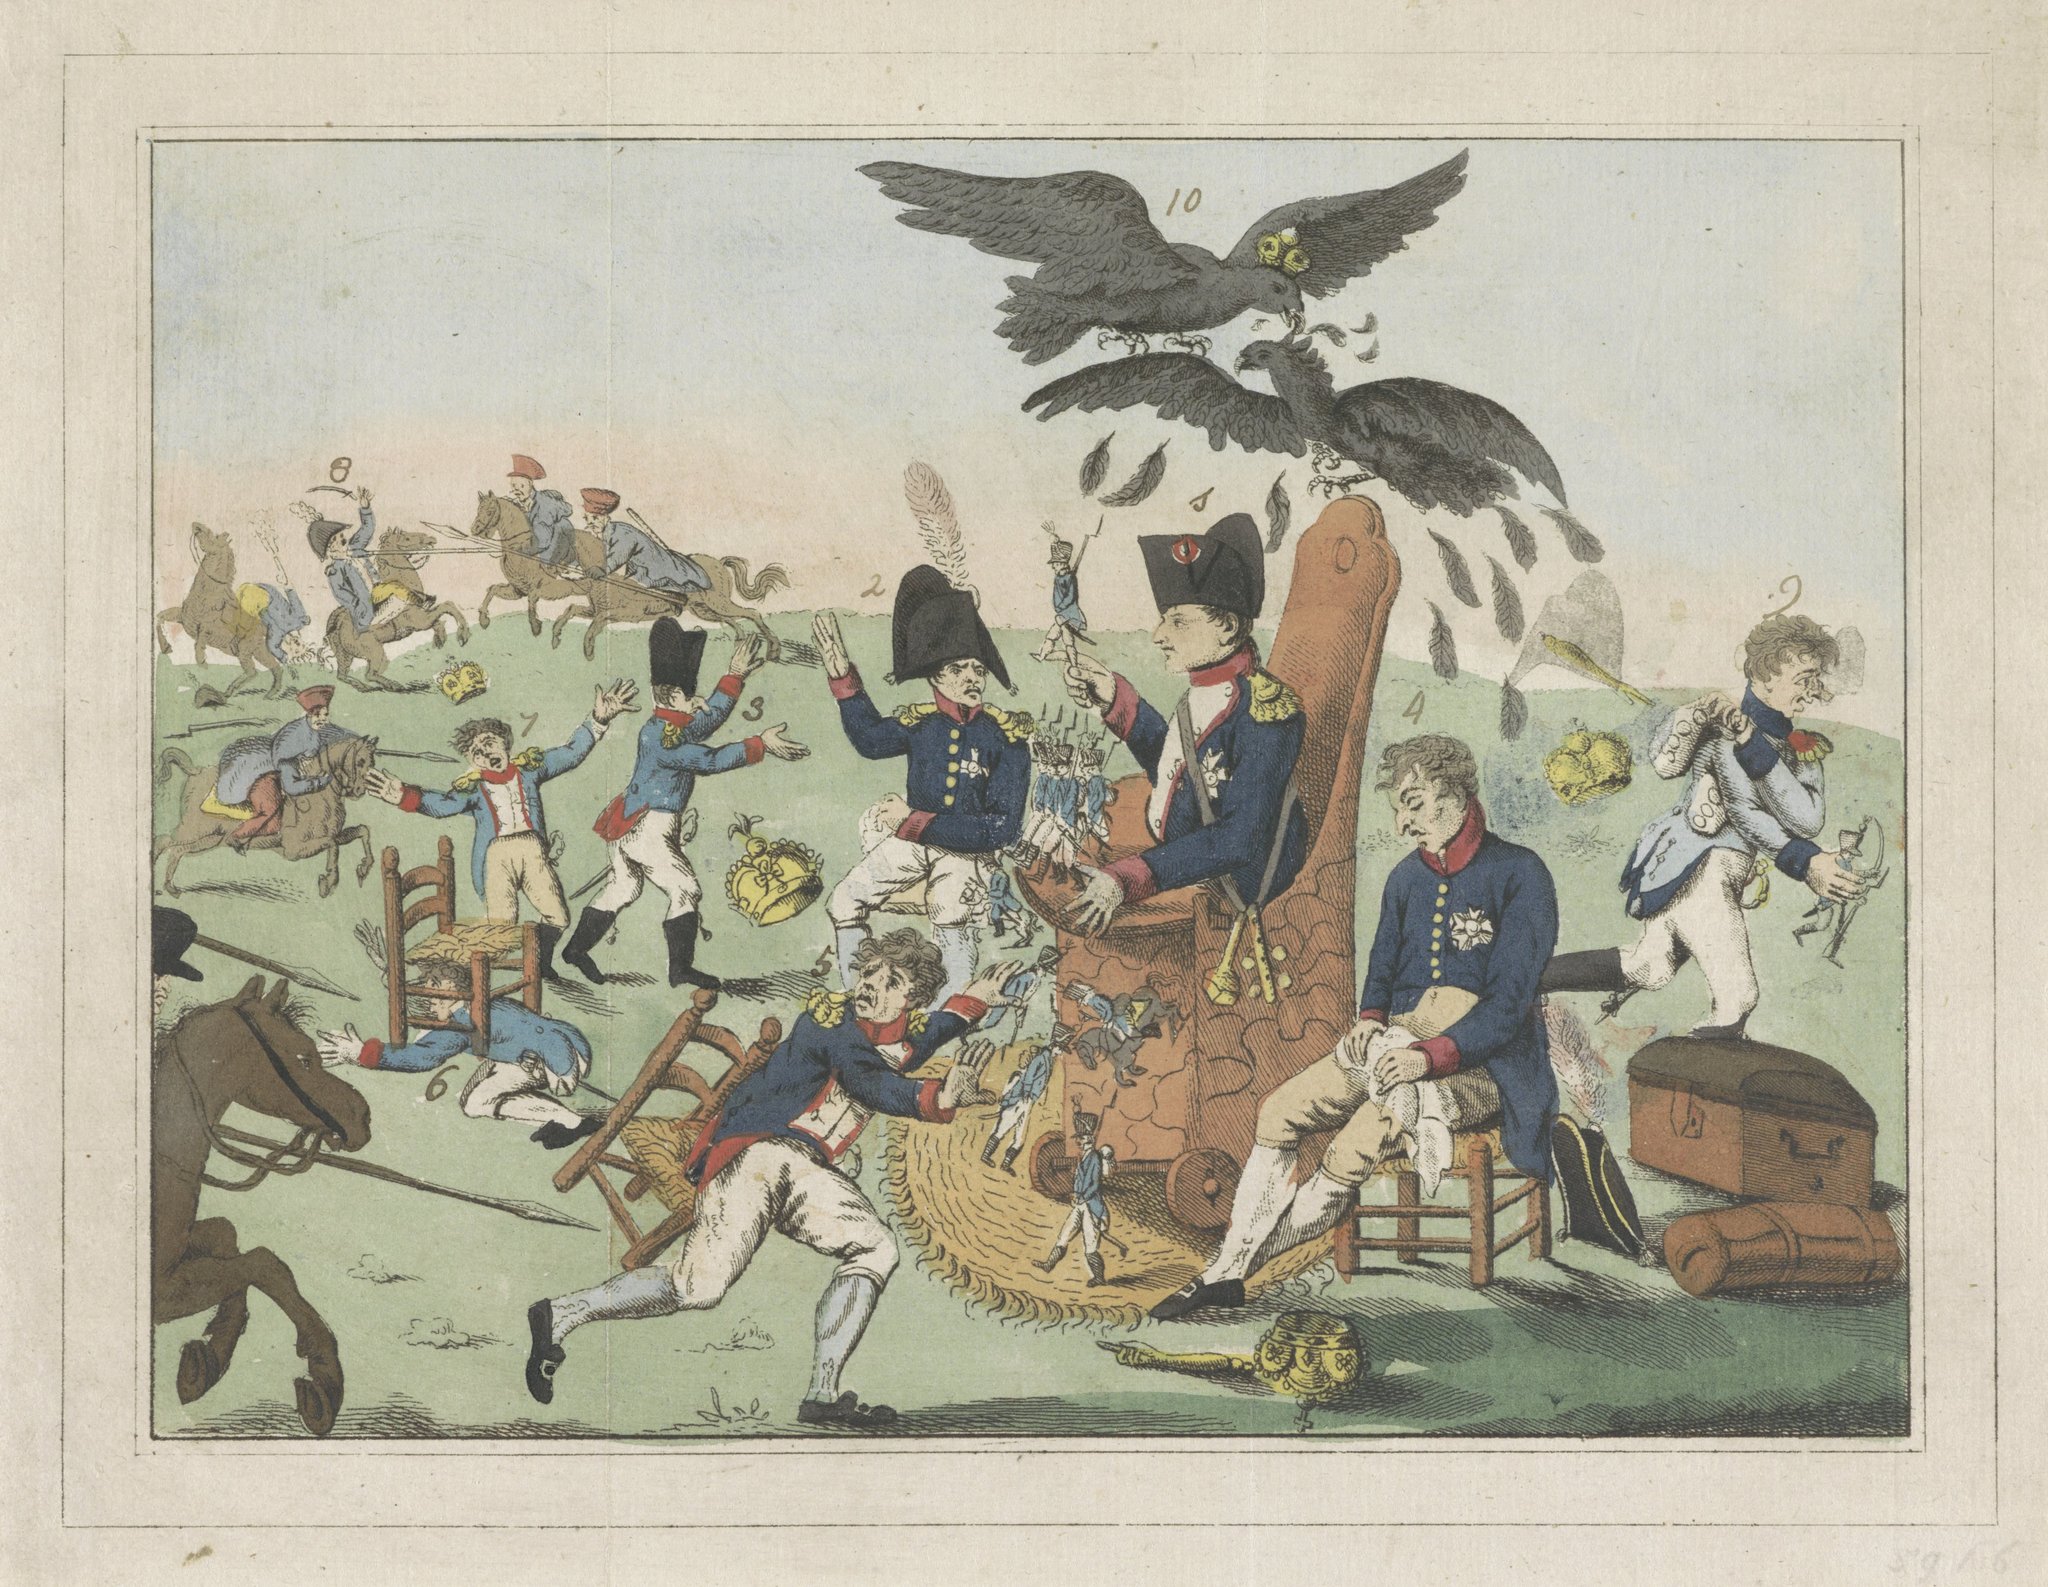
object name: print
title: Napoleon in de Kakstoel, 1813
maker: Anonymous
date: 1813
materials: paper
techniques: etching, hand coloring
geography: netherlands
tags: paris, louis napoleon (king of holland), napoleon i (emperor of the french), baby-chair, (playing with) dolls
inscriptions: collector's mark: Lugt 2228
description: Spotprent op Napoleon na de nederlaag in de slag bij Leipzig, 1813. Napoleon heeft zijn verstand verloren en zit in een kakstoel met speelgoedsoldaatjes te spelen. Links van de keizer een boze generaal. De drie broers van Napoleon verliezen hun kronen: rechts zit zijn broer Joseph Bonaparte, koning van Spanje, verslagen op een stoel. Op de voorgrond wordt zijn broer Jérôme Bonaparte, koning van Westfalen, achterna gezeten door een kozak. Links meer naar achteren heft Lodewijk Napoleon in wanhoop zijn handen in de lucht. Rechts vlucht De Celles. Veel van de Fransen in de voorstelling worden achterna gezeten door kozakken te paard. In de lucht vechten de Duitse en de Franse adelaars. Bij de figuren in de voorstelling zijn met de hand nummers geschreven die corresponderen met de nummers in de bij de prent behorende afzonderlijke verklaring.